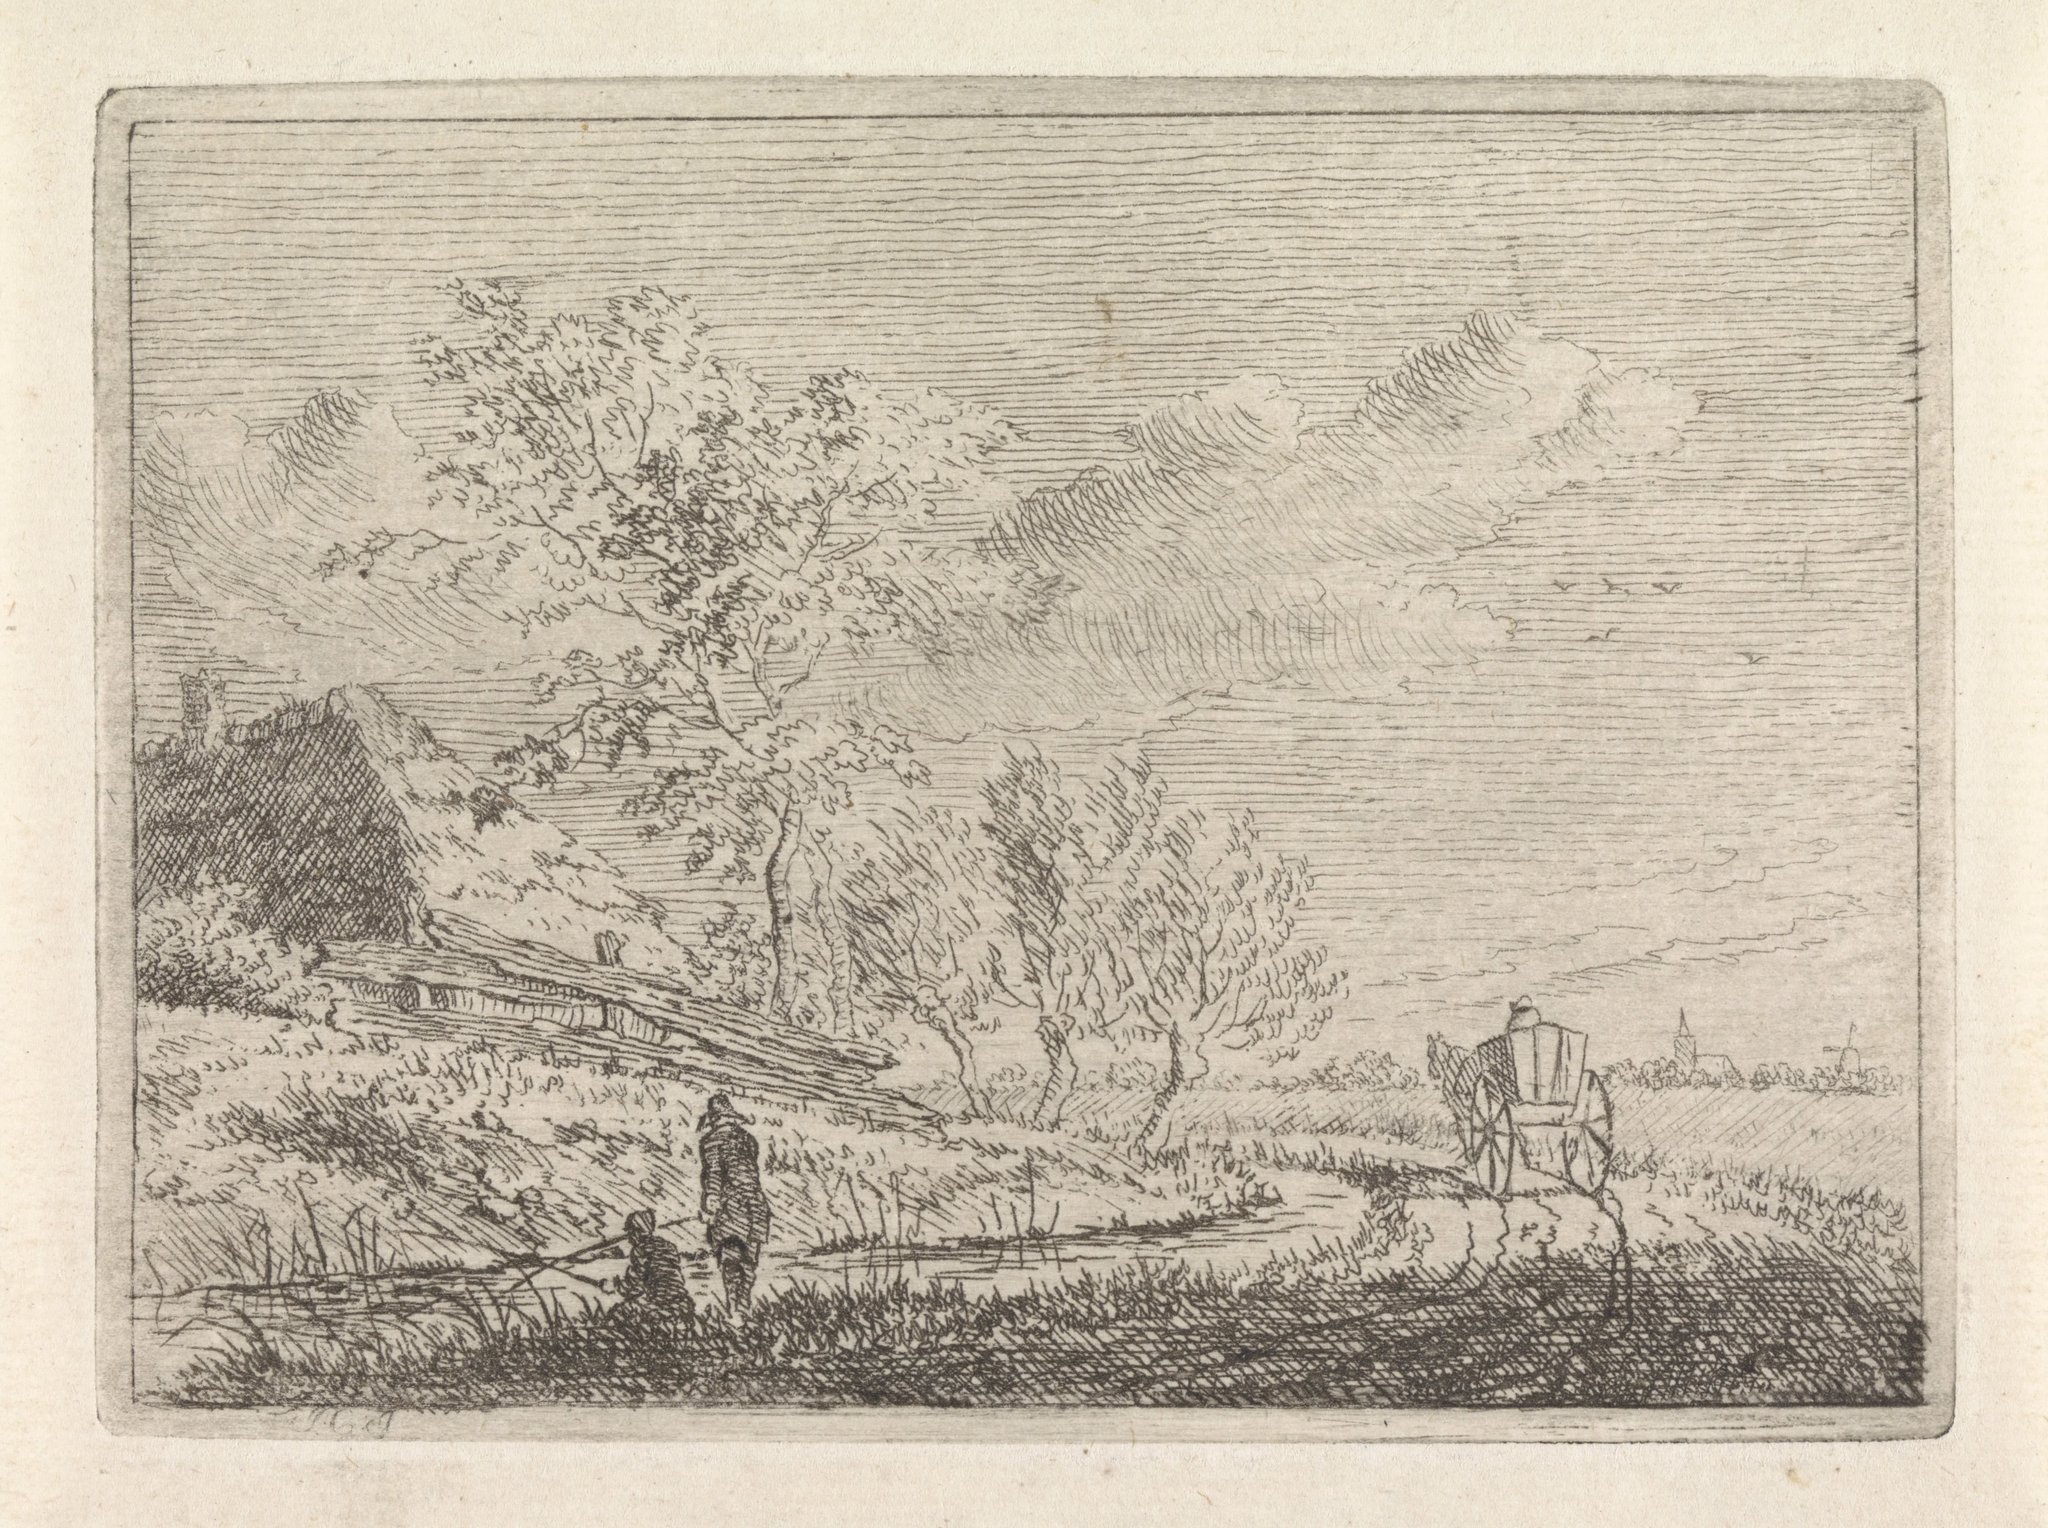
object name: print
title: Landschap met kar en twee vissers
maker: johannes christiaan janson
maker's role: draughtsman, painter, print maker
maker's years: 1763-1823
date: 1778-1823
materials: paper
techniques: etching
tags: farm or solitary house in landscape, fisherman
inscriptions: collector's mark: Lugt 240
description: Landschap met langs een sloot een weg met daarop een kar. Links een boerderij en op de voorgrond twee vissers.